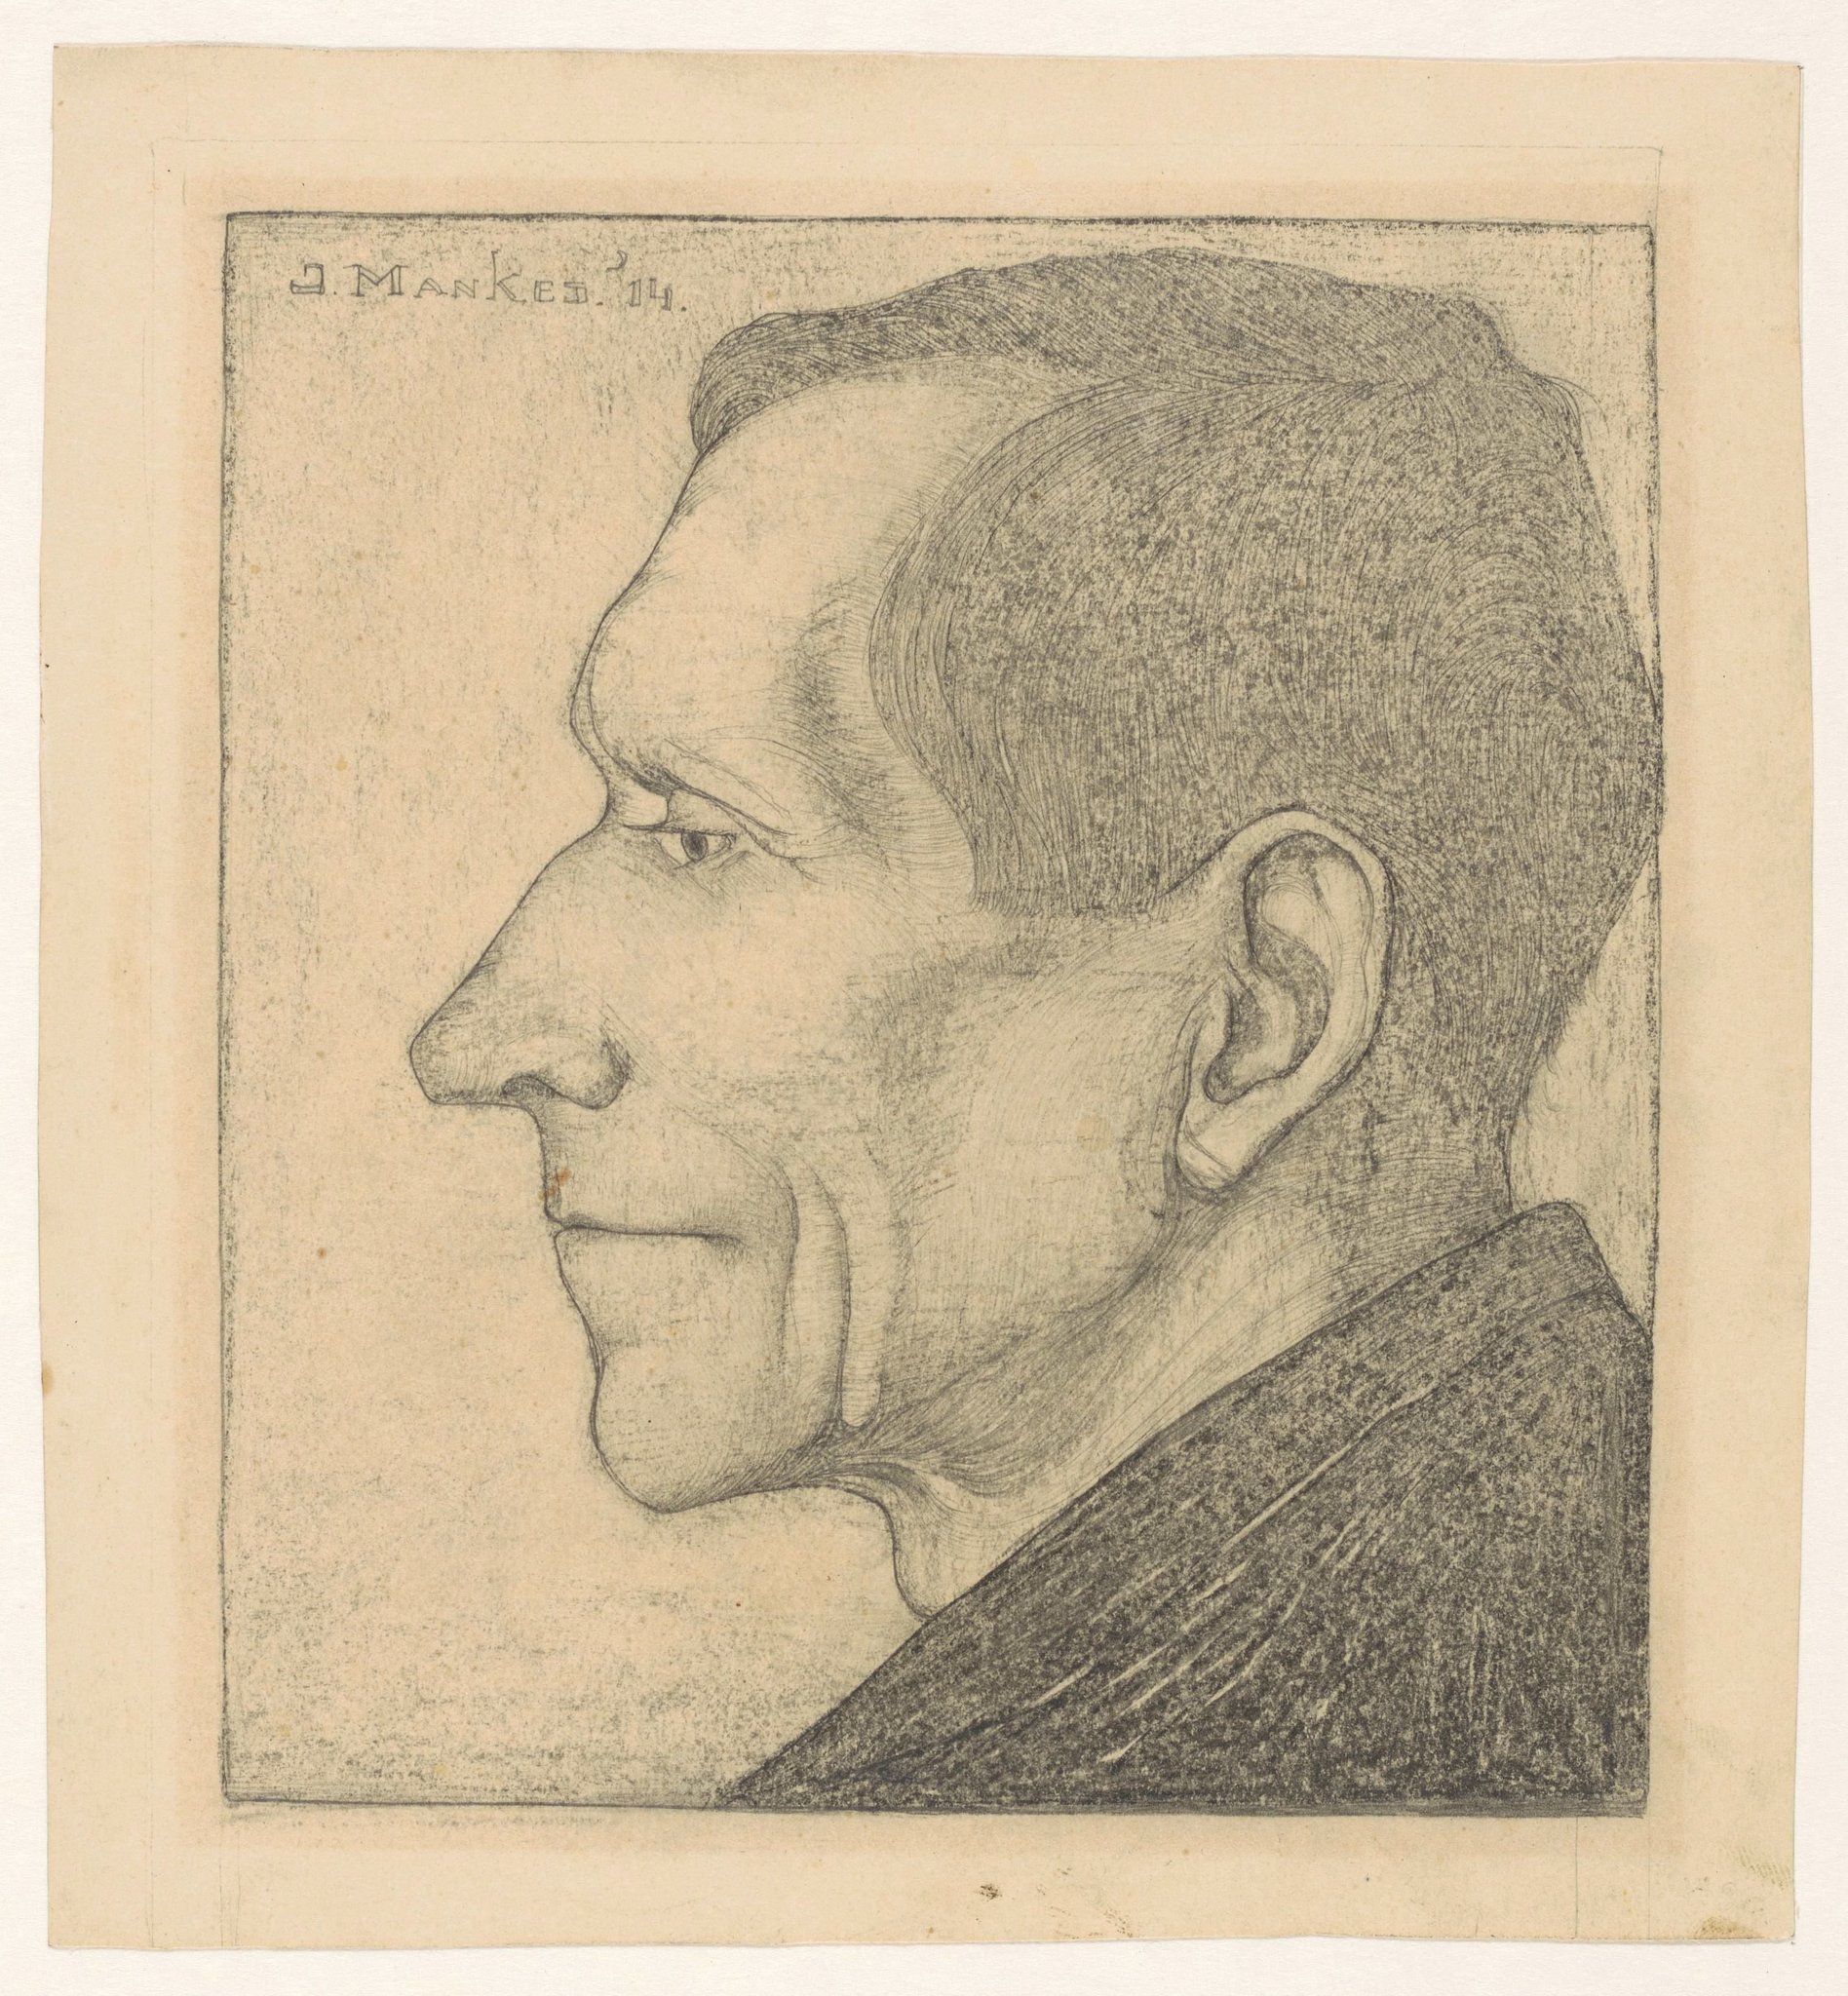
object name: design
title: Portret van Beint Mankes I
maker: jan mankes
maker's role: draughtsman, painter, print maker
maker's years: 1889-1920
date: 1914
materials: chalk, paper, pencil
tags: historical persons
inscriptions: collector's mark: Lugt 2228